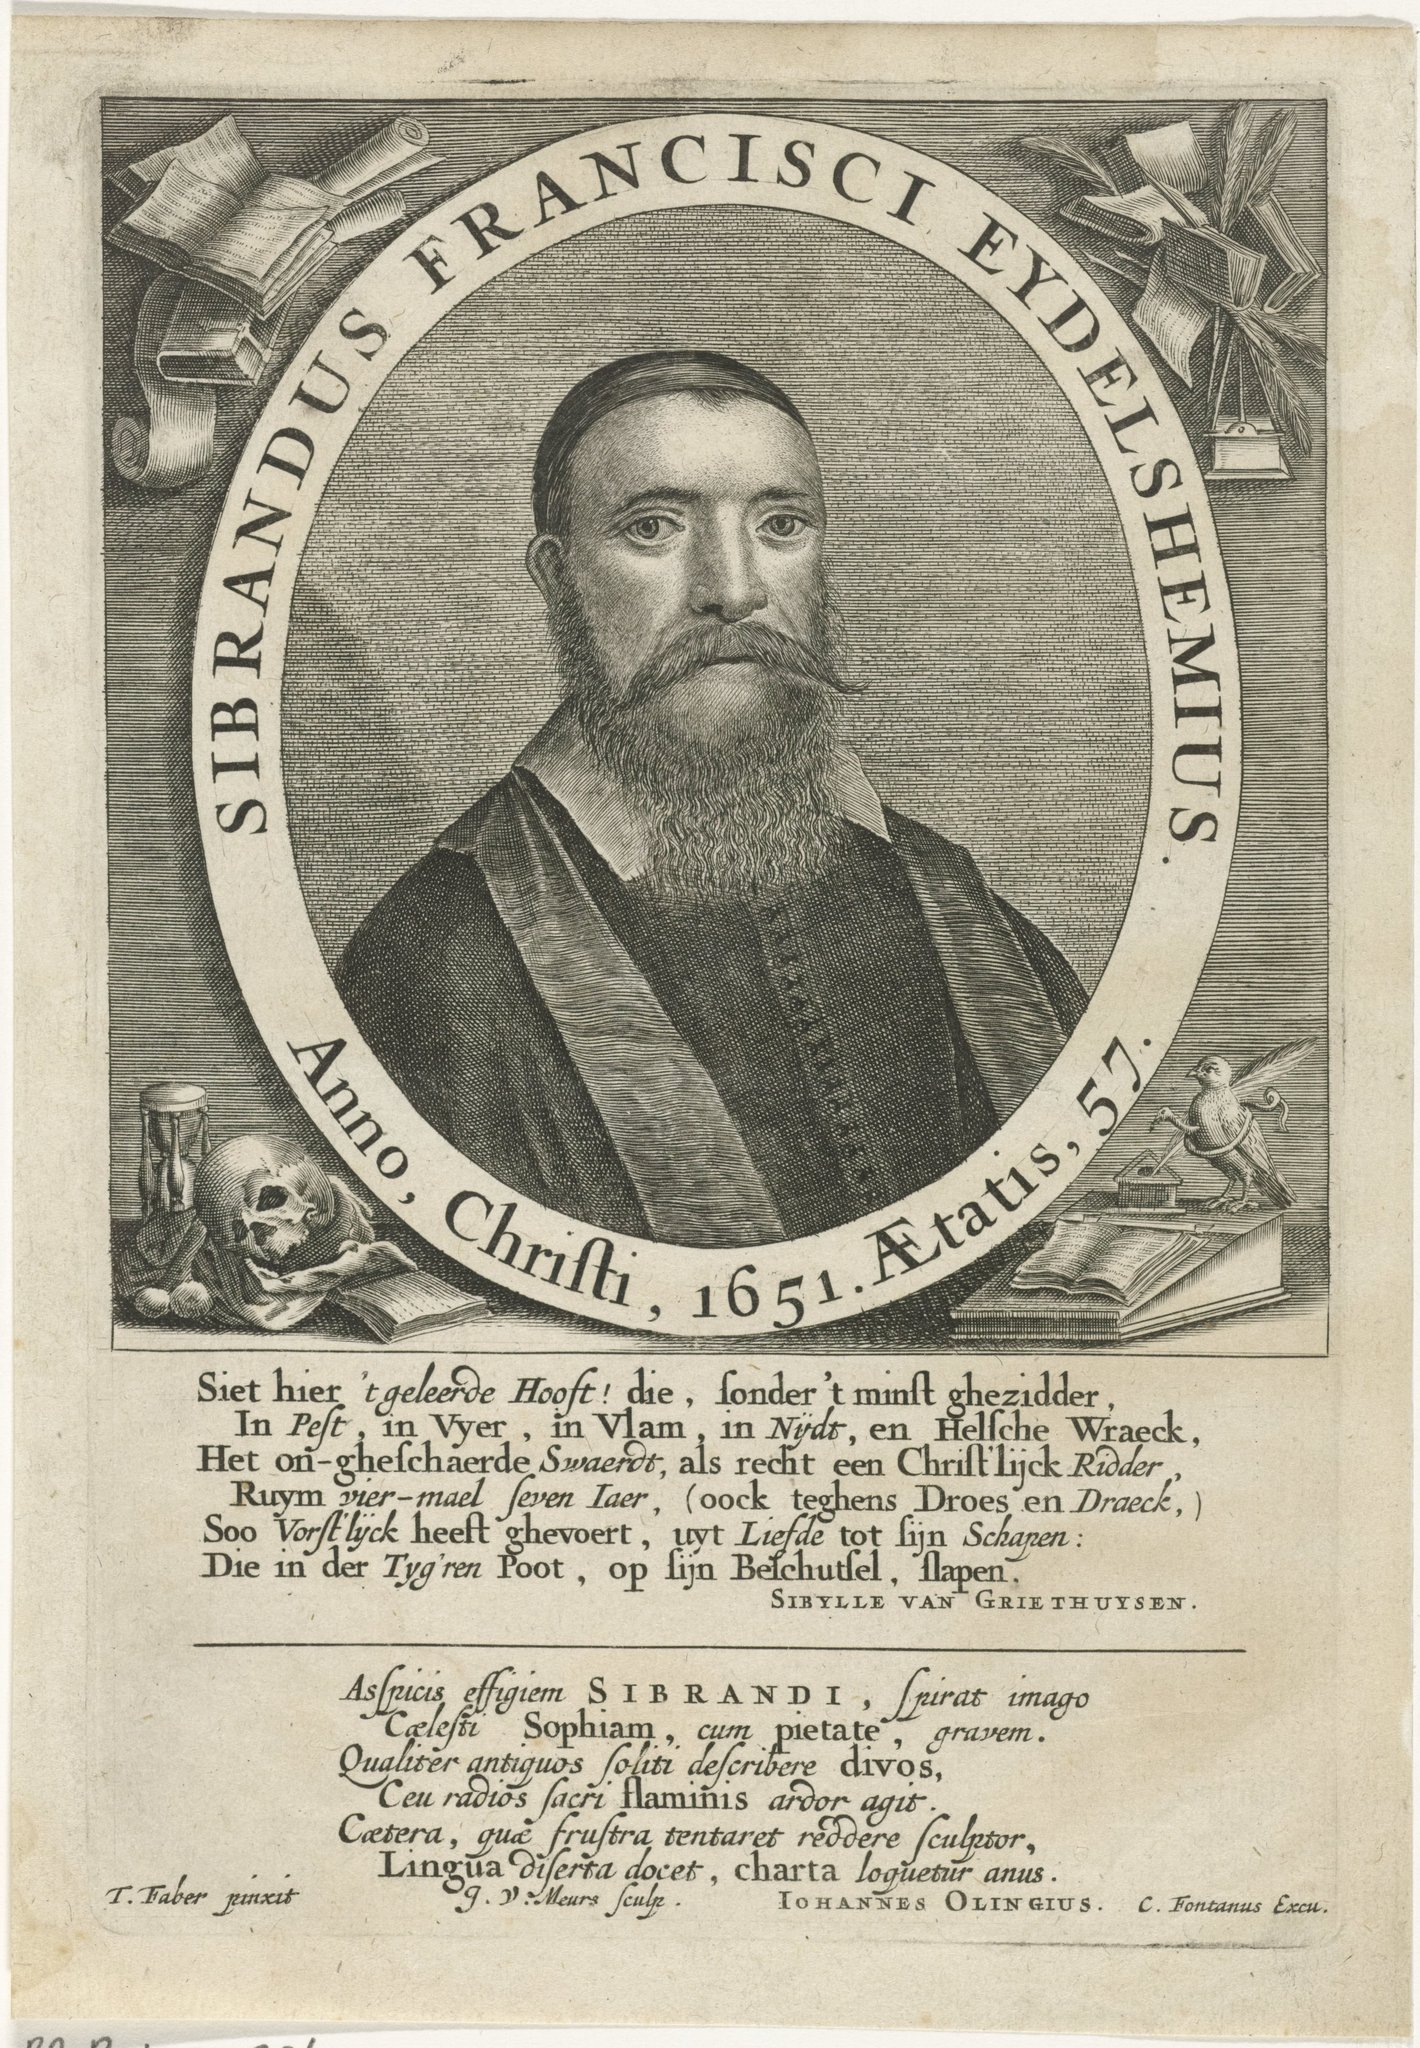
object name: book illustration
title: Portret van Sibrandus Francisci Eilshemius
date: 1651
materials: paper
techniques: engraving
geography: amsterdam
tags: sibrandus francisci eilshemius, skull as symbol of 'vanitas', hourglass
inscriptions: collector's mark: Lugt 2228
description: Prent gebruikt in: Griethuysen, Sybille van en Sibrandus Franciscus Eilshemius. Hemelsche troost-borne, teghen de banghste aen-vechtinghe; om de over-blĳffselen der zonde. Leeuwarden: Claude Fonteyne, 1651.